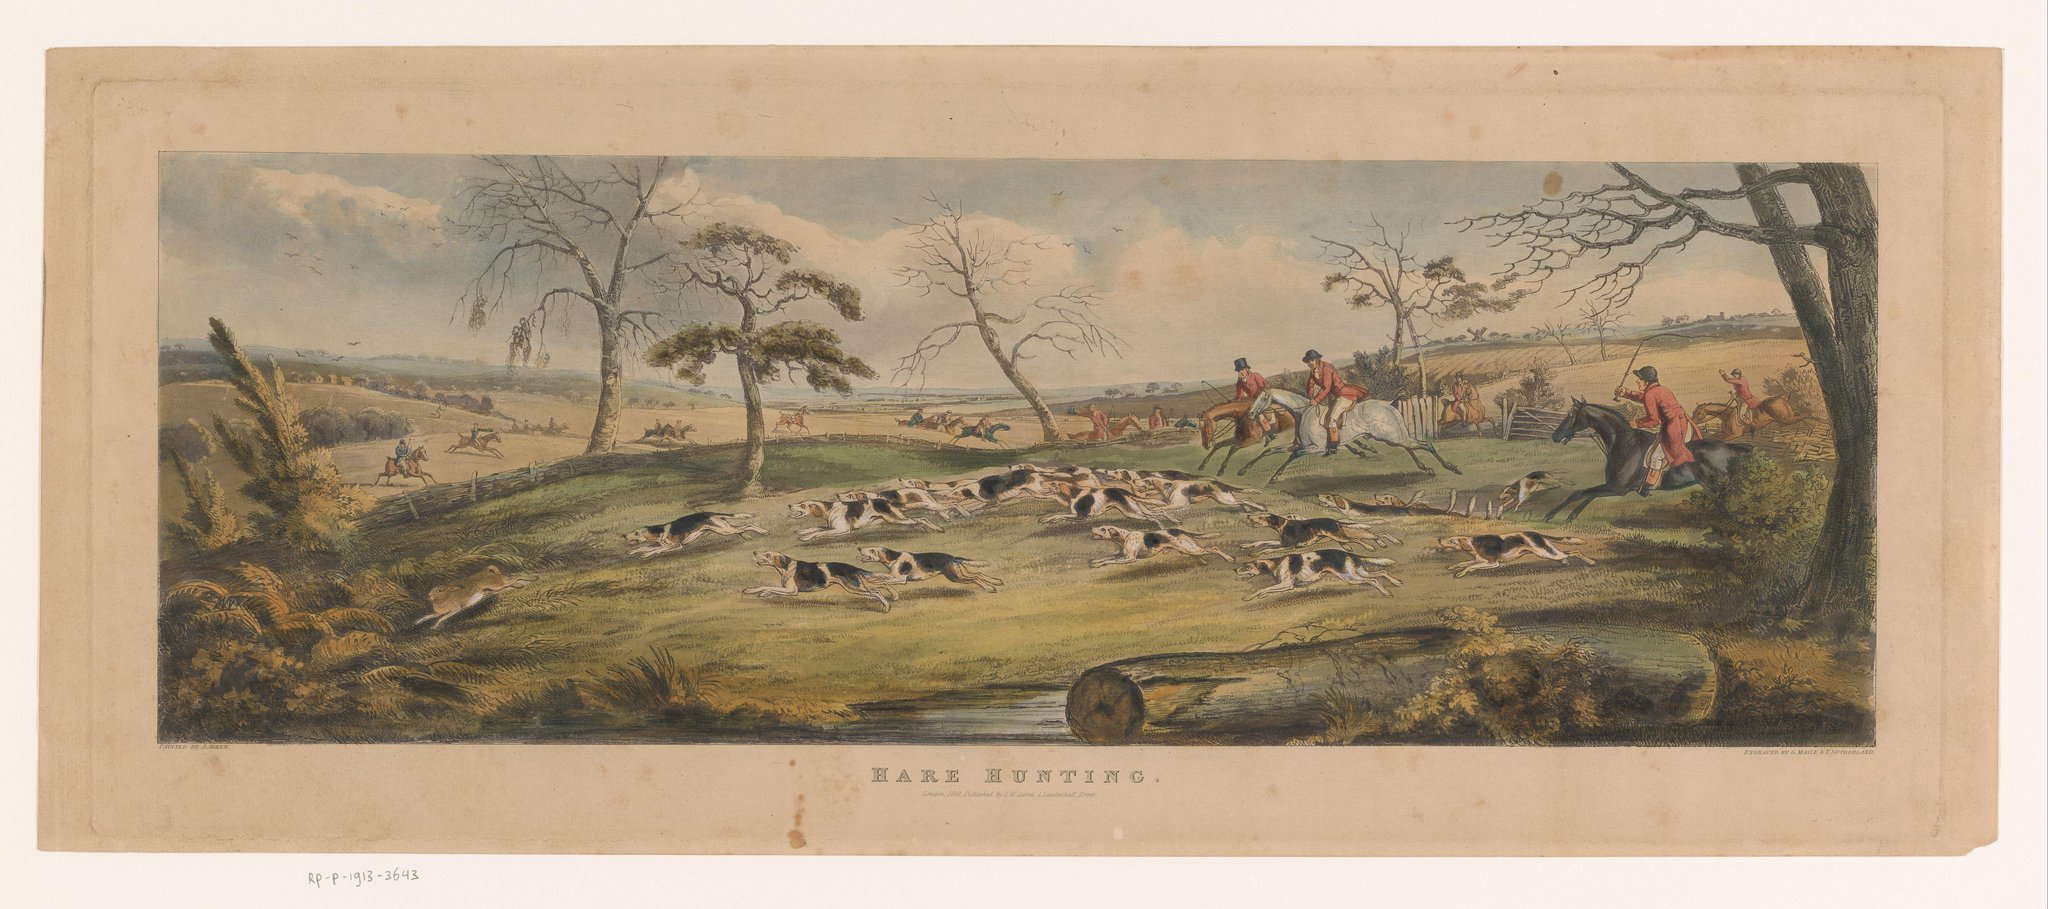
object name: print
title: Meute beagles jaagt op een haas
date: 1841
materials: paper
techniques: aquatint, etching, hand coloring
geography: london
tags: riding a horse, ass, or mule; rider, horseman, low hill country, hunting dogs, dog (with name of kind), hare-hunting, rabbit-hunting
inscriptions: collector's mark: Lugt 2233